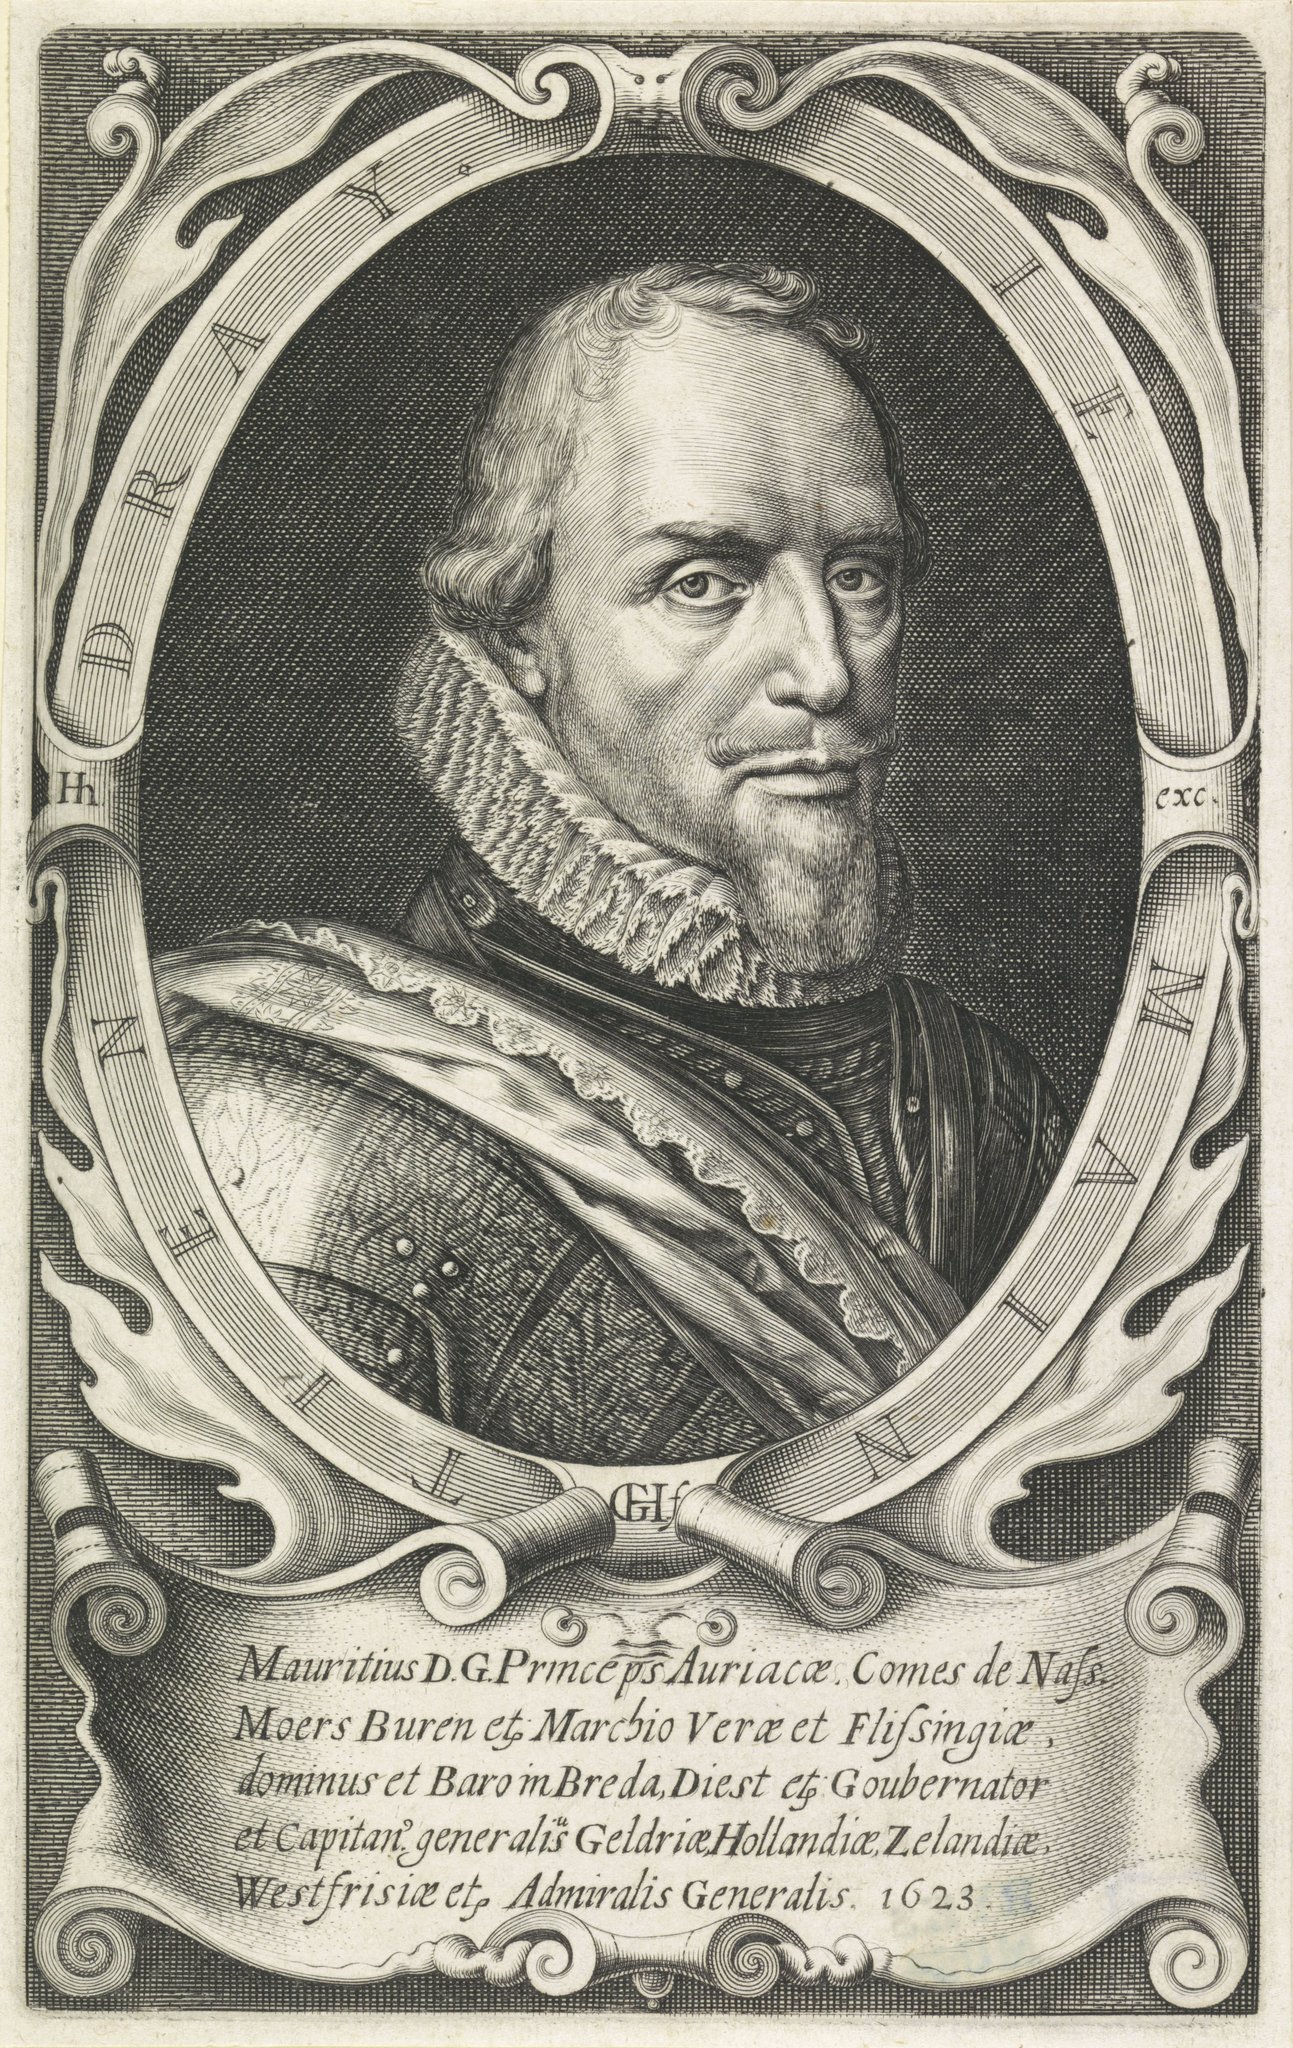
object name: print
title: Portret van Maurits, prins van Oranje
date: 1623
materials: paper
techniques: engraving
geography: the hague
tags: the hague, maurice (prince of orange)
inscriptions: collector's mark: Lugt 963, collector's mark: Lugt 2165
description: De hier vermelde titel verwijst naar de hoogst verkregen titel van de geportretteerde, niet per se naar de titel die de geportretteerde op deze voorstelling draagt.